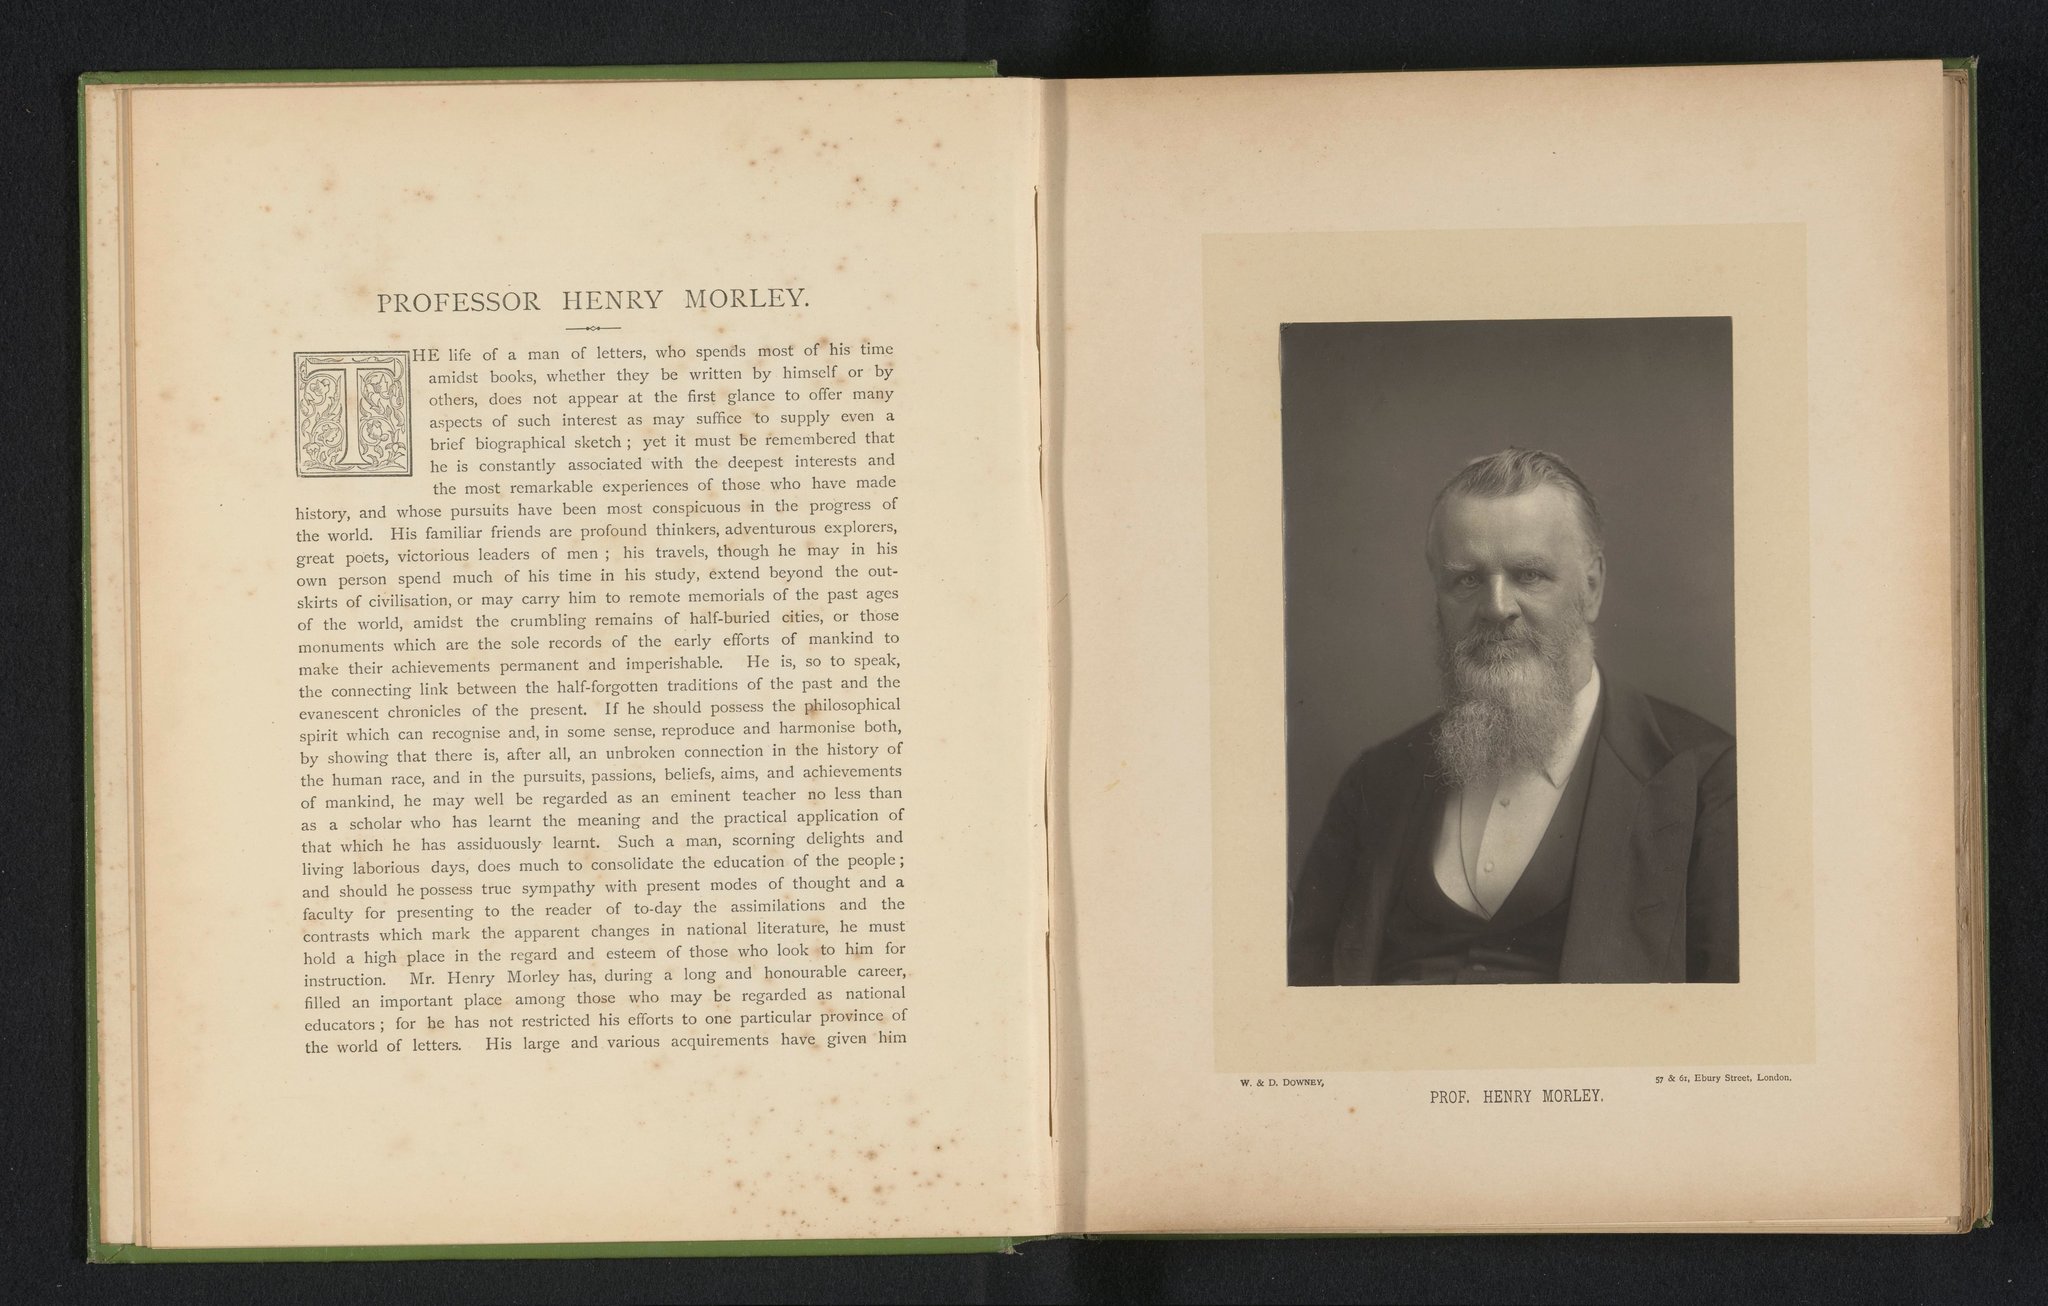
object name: photomechanical print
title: Prof. Henry Morley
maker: Anonymous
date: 1884-1894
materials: paper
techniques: woodburytype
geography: london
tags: portrait of a writer, professor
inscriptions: inscription: ‘57 & 61, Elbury Street, London.’